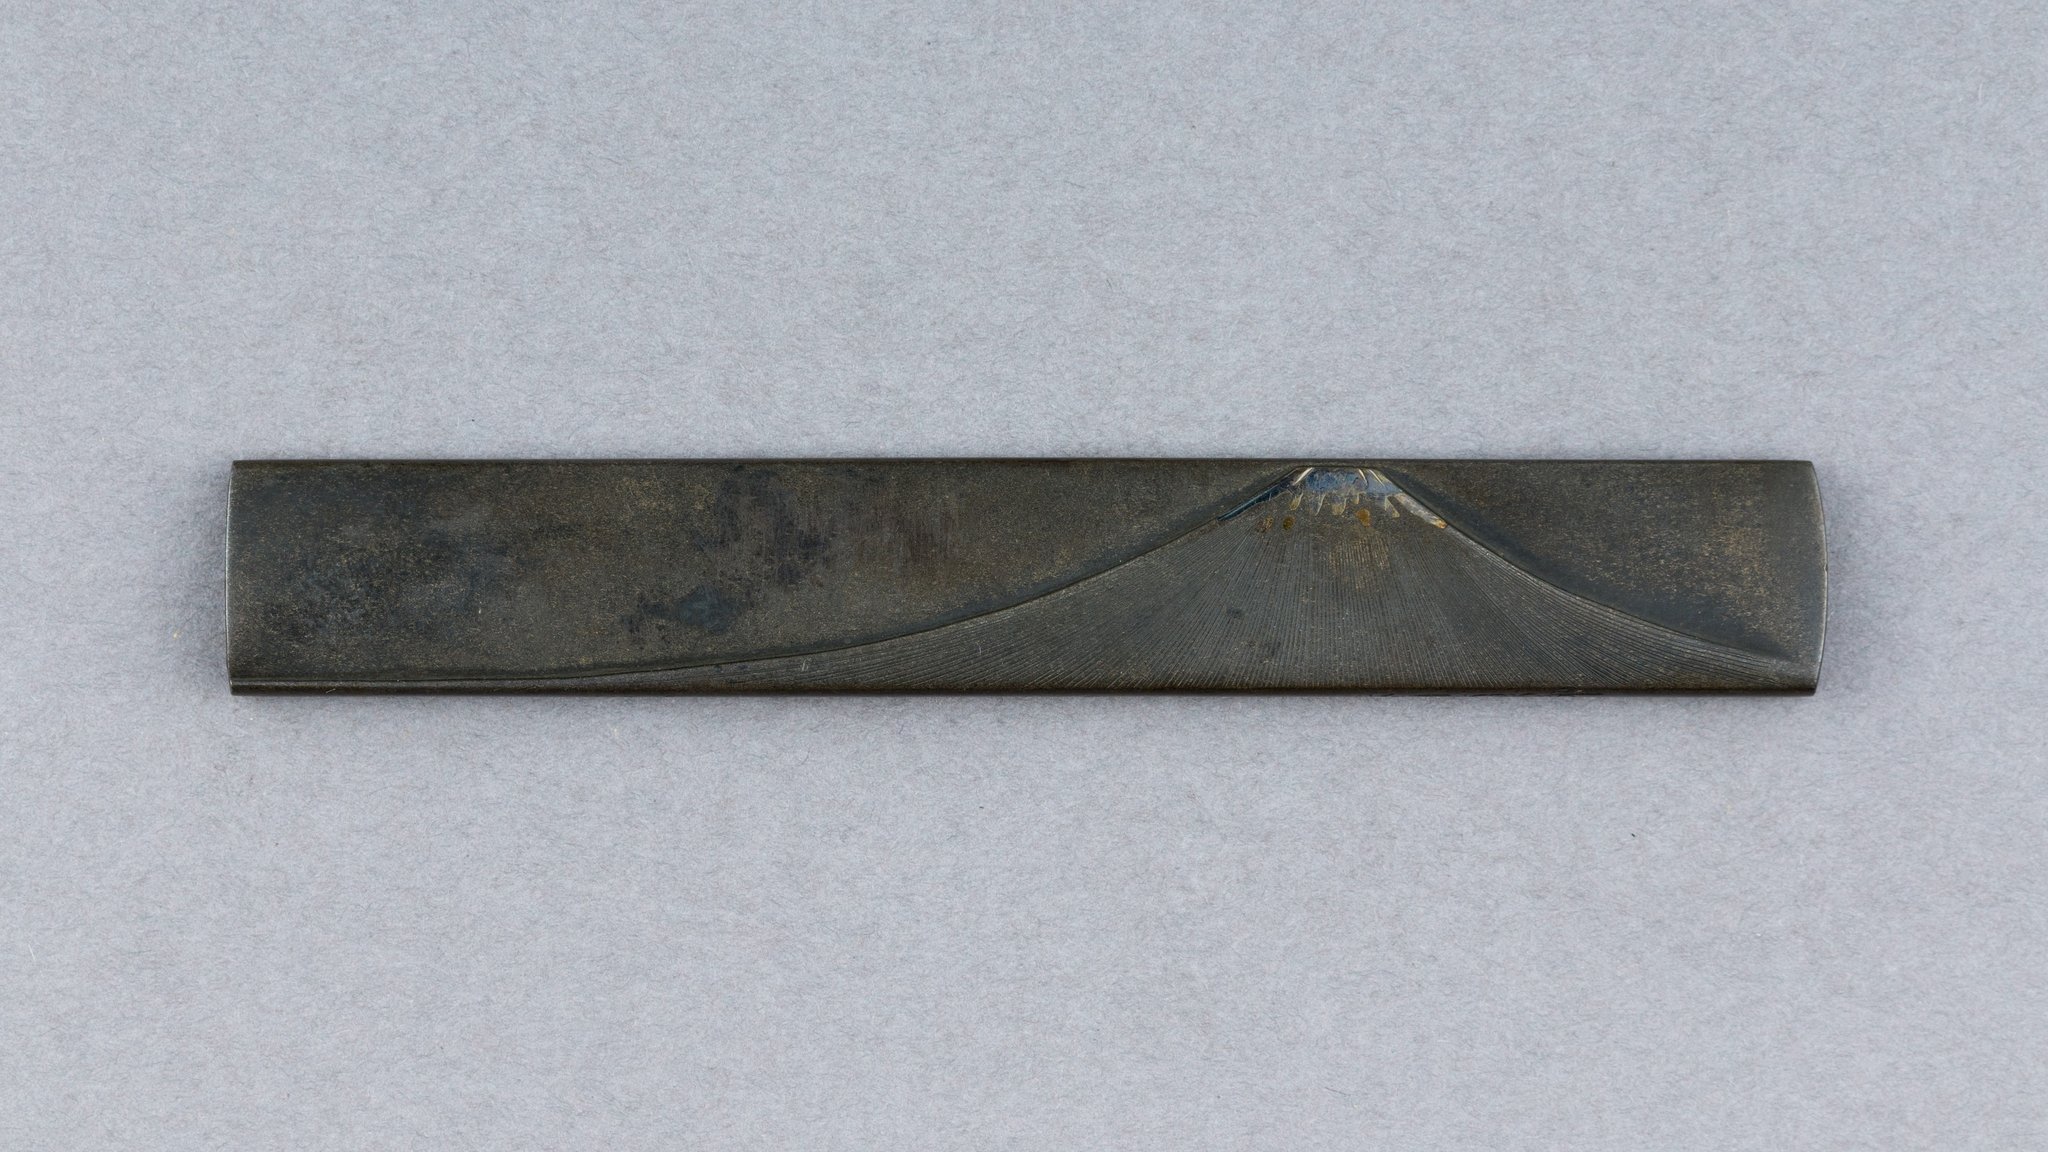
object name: knife handle kozuka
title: Knife Handle (Kozuka)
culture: japanese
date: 1801-1900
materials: silver alloy, silver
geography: japan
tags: mountains